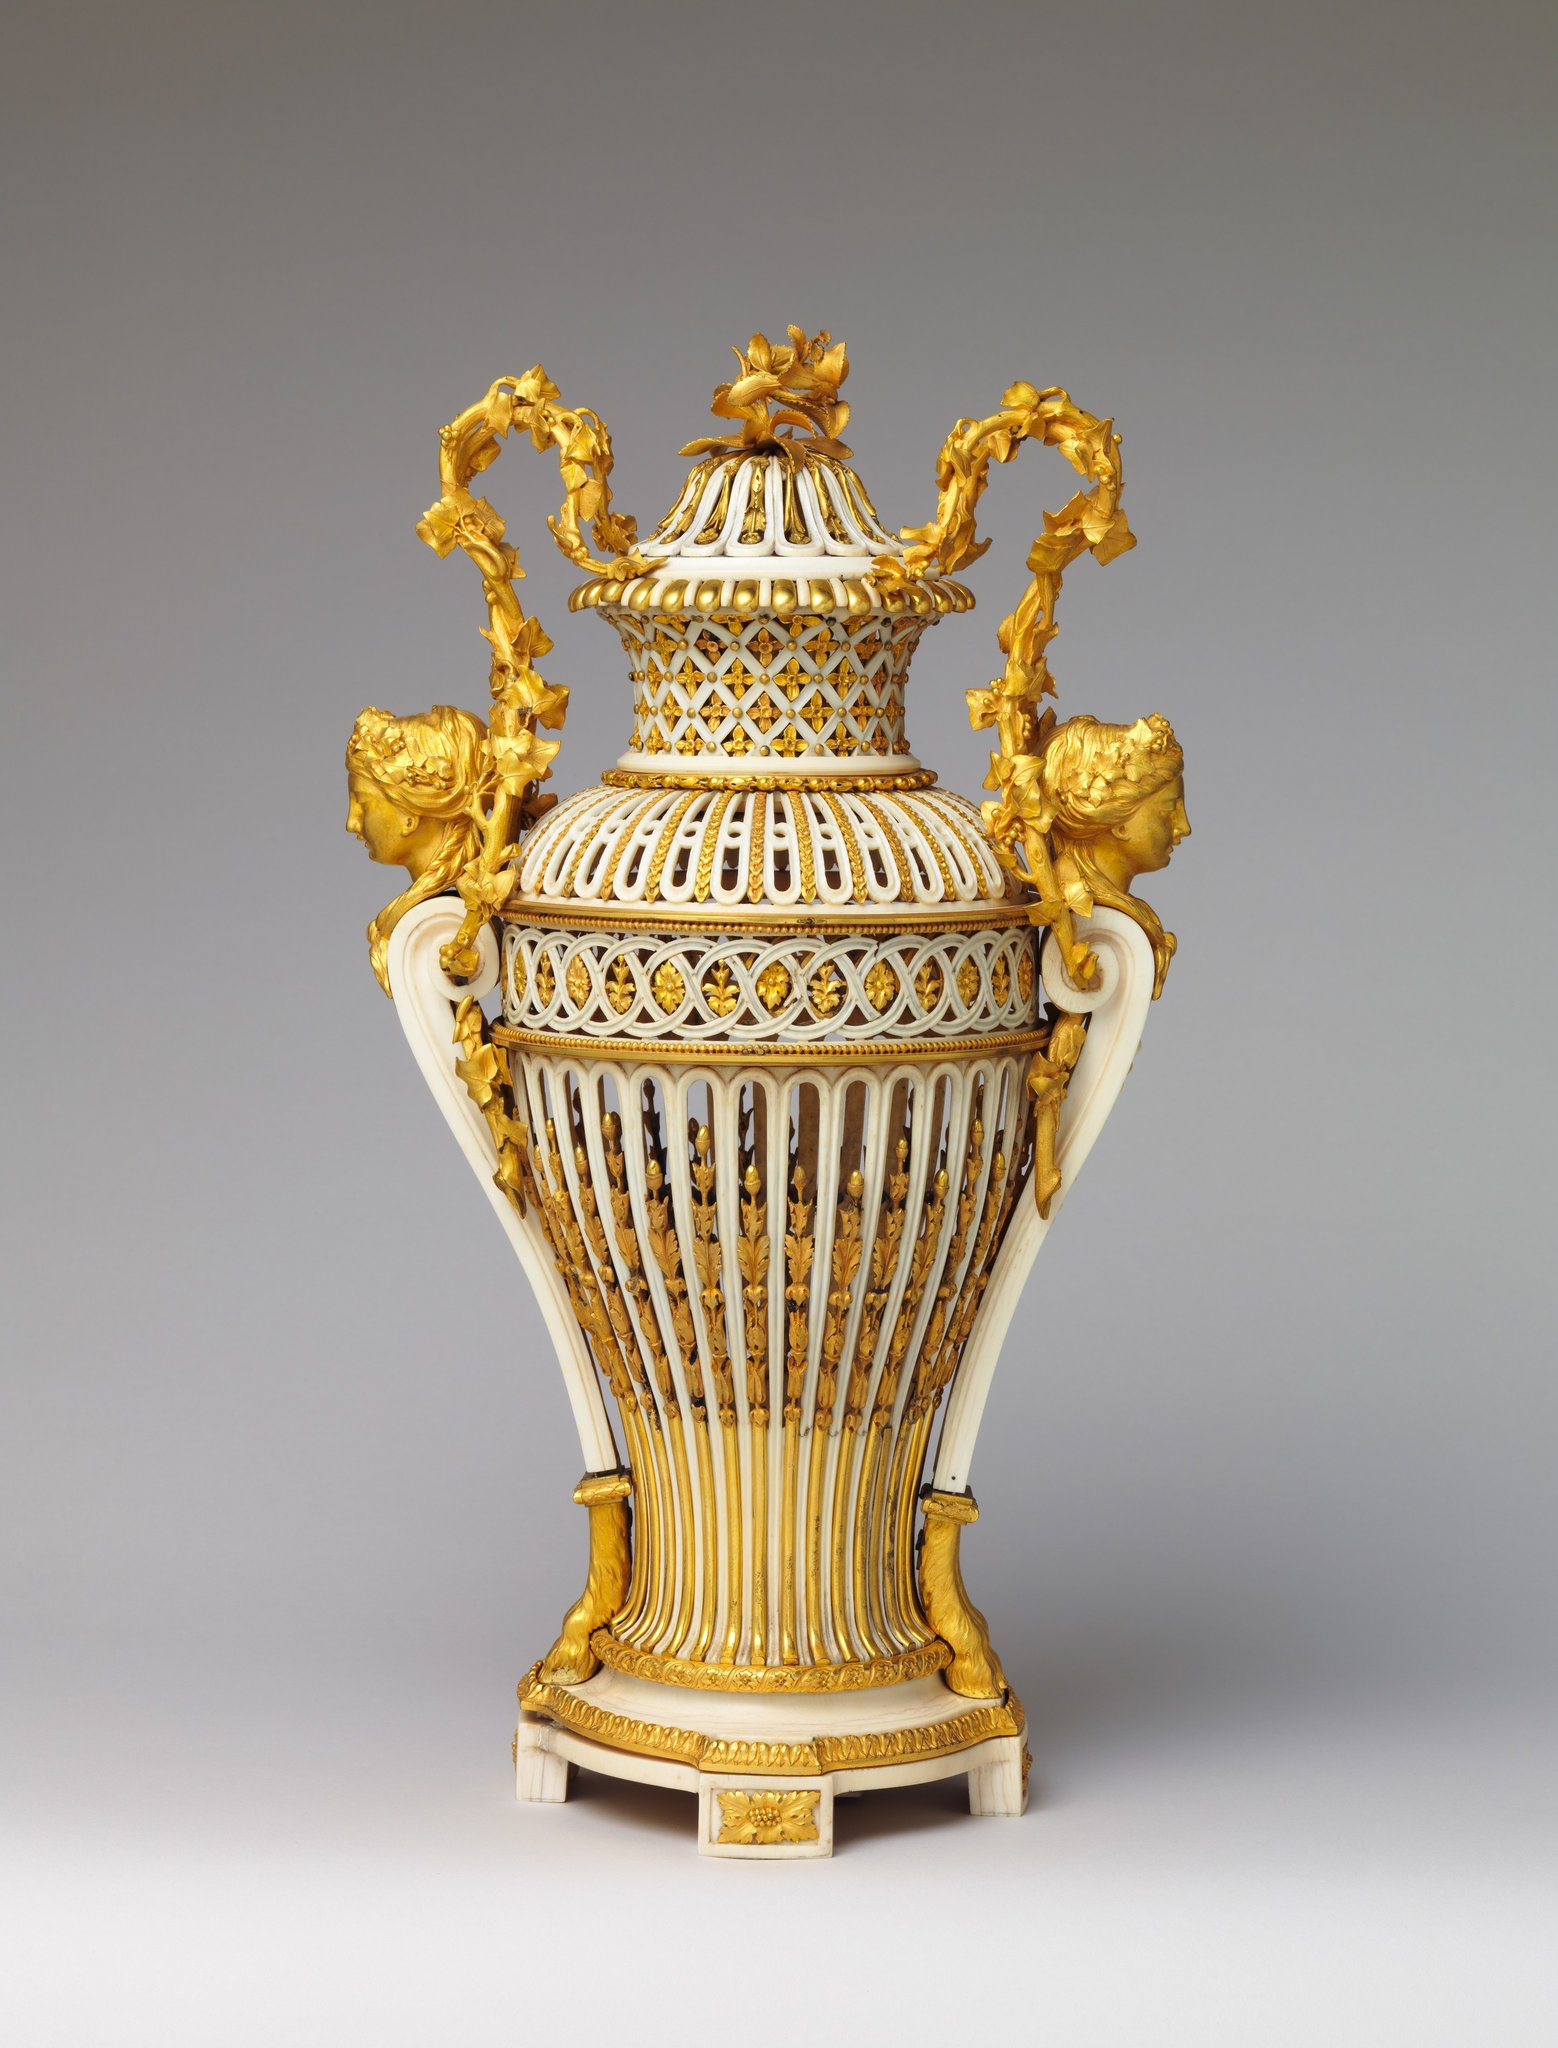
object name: vase with cover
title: Vase with cover (Vase en ivoire) (one of a pair)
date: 1786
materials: gilt bronze, ivory